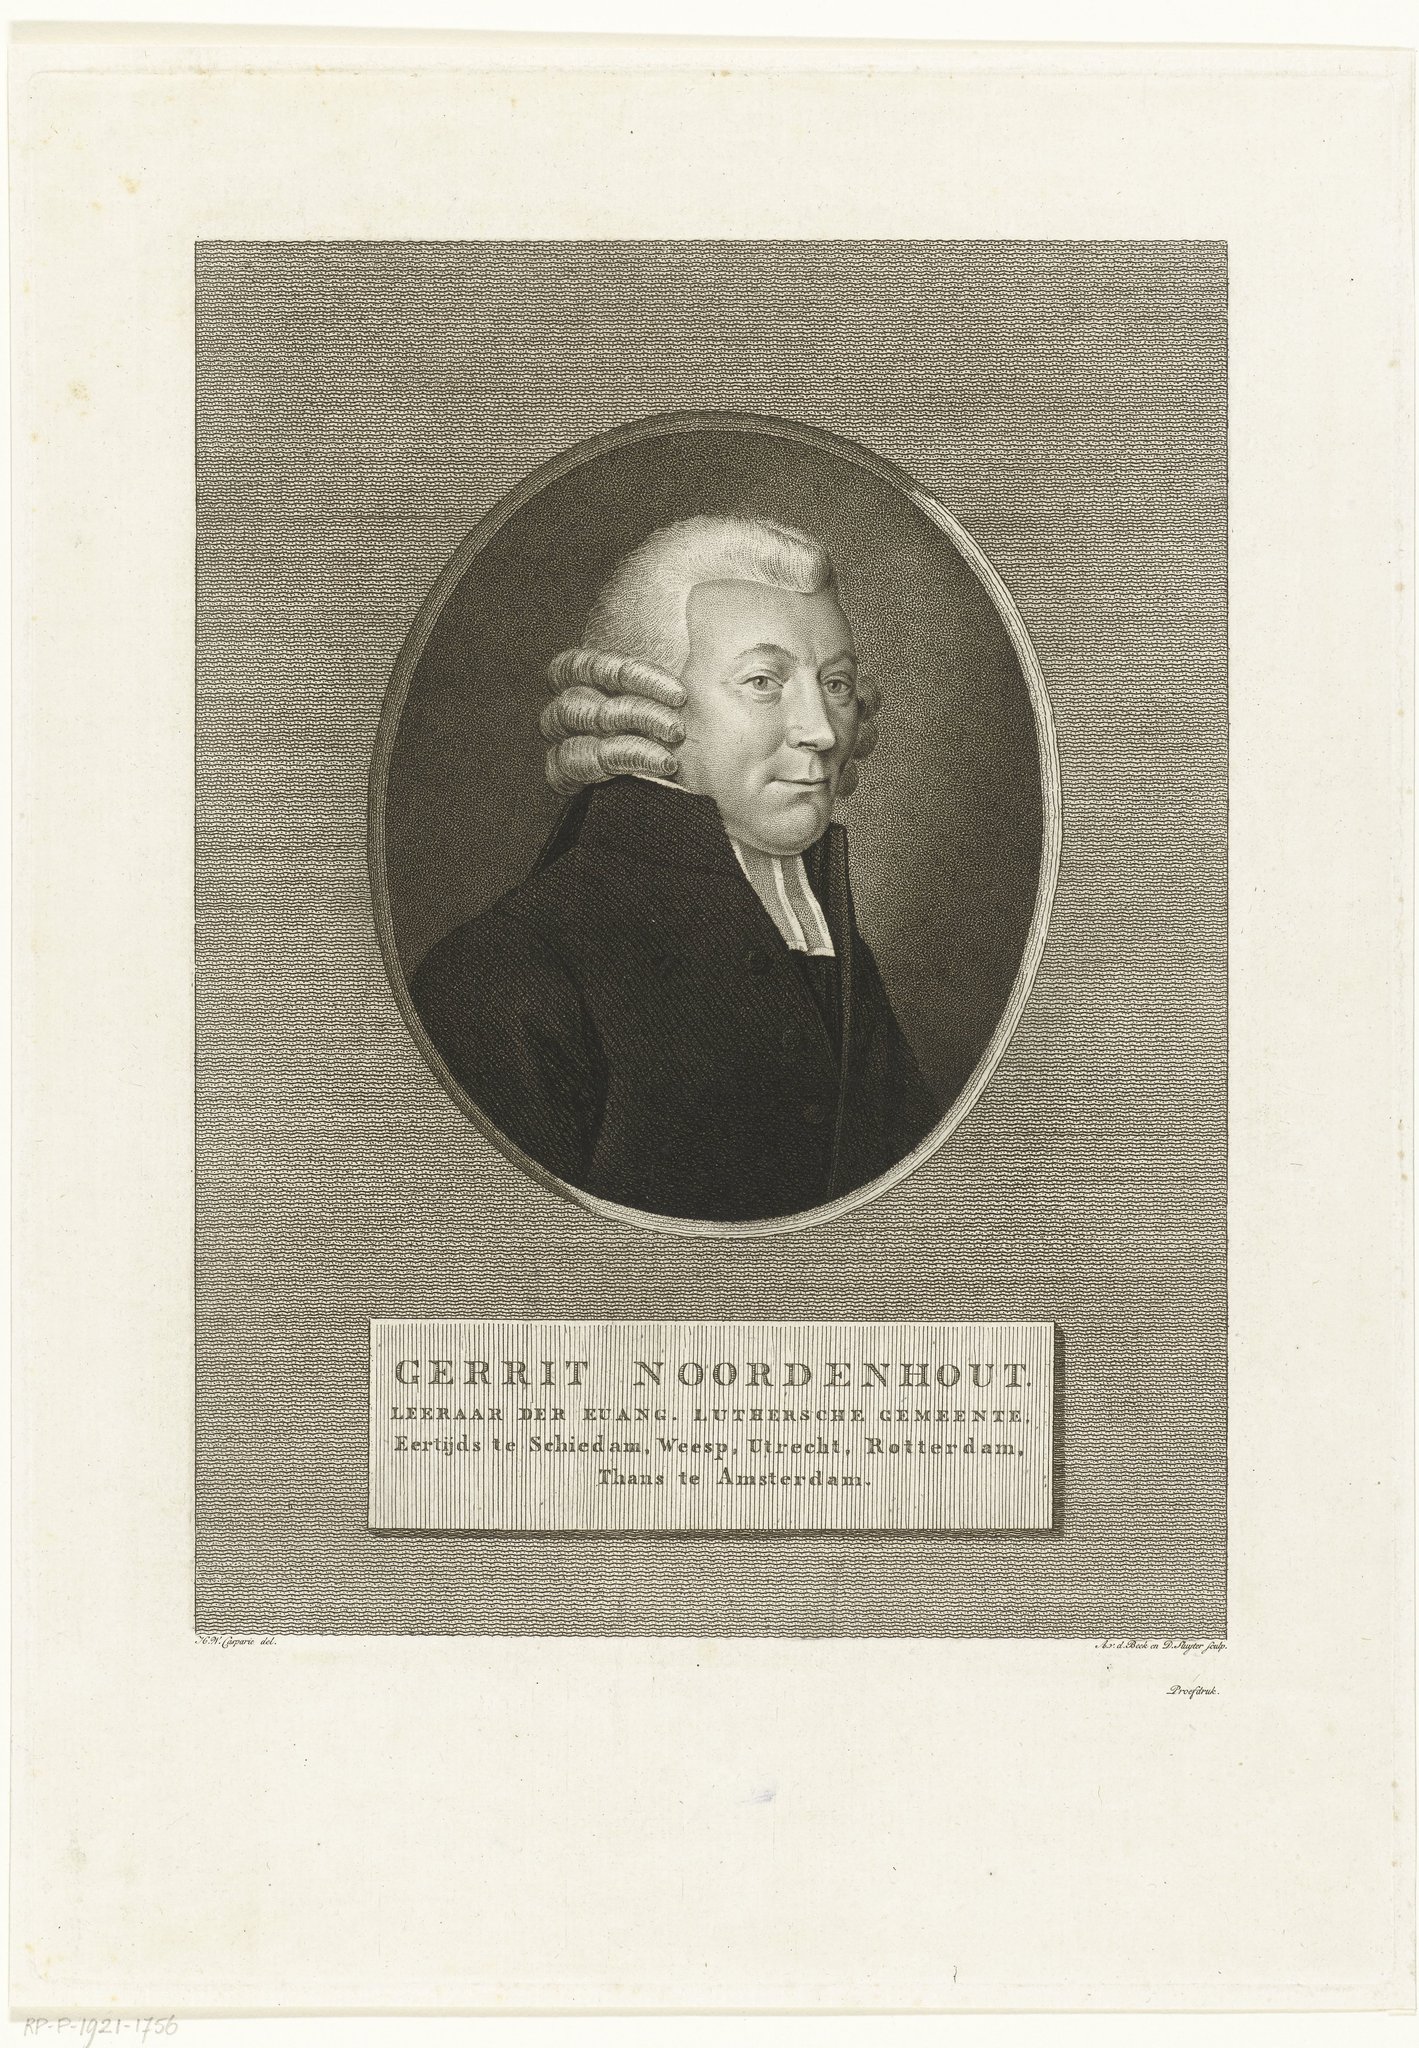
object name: print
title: Prent van Lutherse predikant Gerrit Noordenhout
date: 1800-1852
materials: paper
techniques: aquatint, etching, roulette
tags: functionaries and dignitaries (with name) ~ episcopal protestant churches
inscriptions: collector's mark: Lugt 2233, collector's mark: Lugt 2228